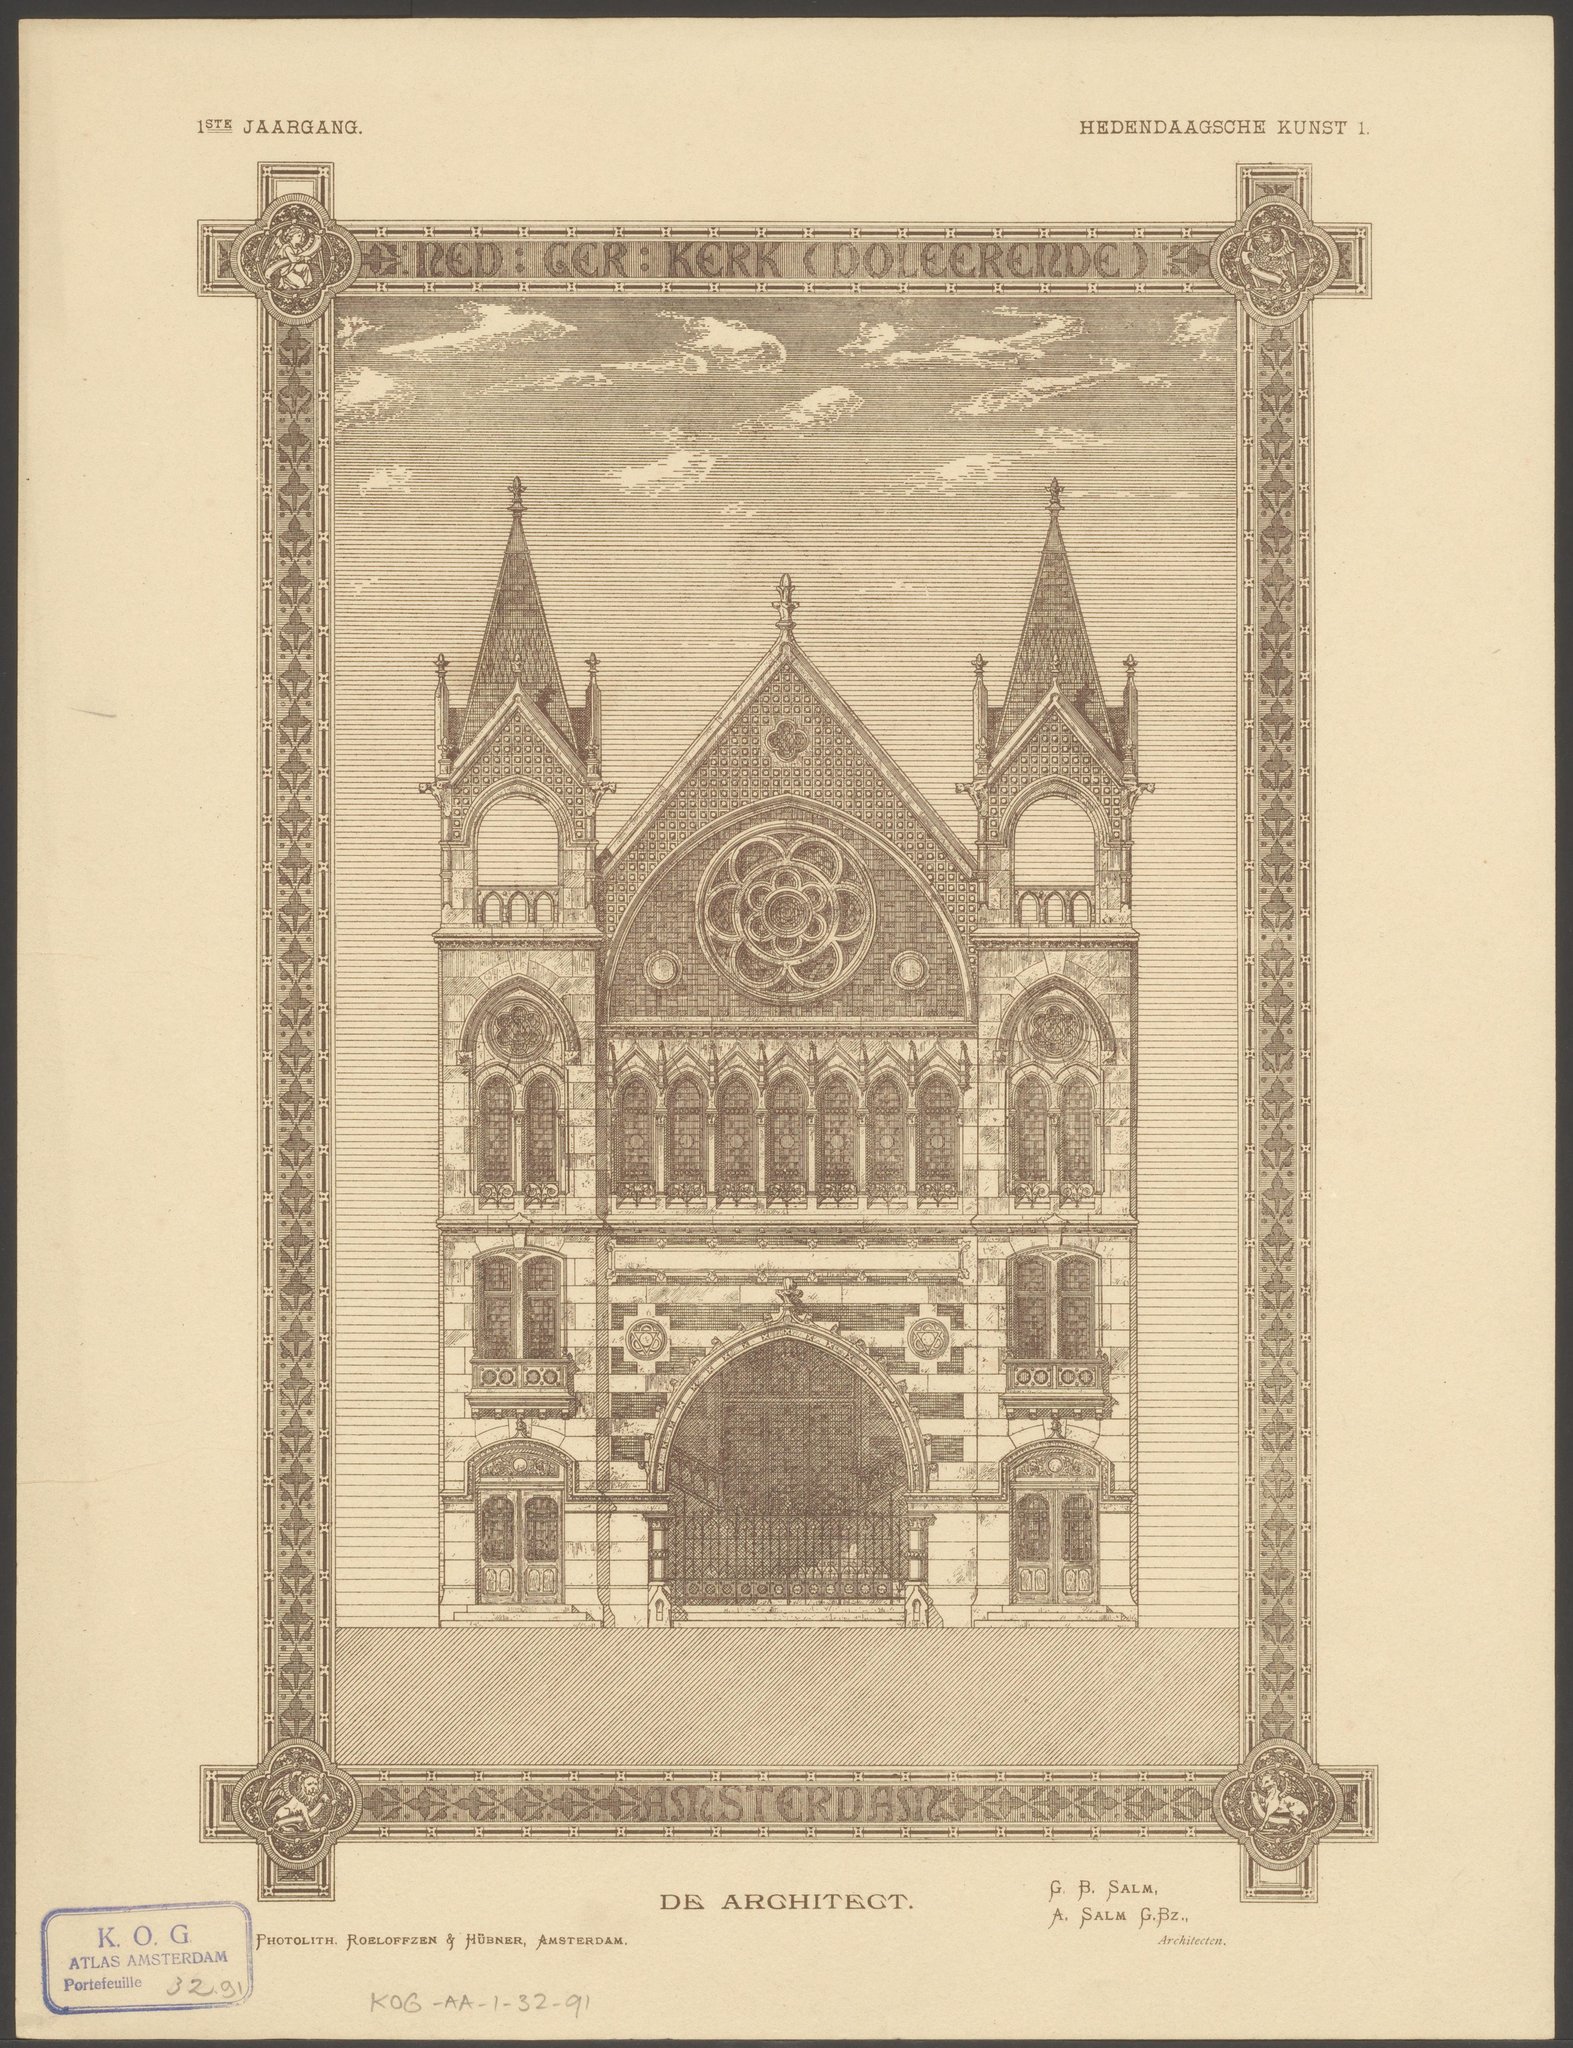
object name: photomechanical print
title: Ned: Ger: Kerk (Doleerende) / Amsterdam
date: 1890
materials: paper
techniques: photolithography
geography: amsterdam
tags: parts of church exterior and annexes: façade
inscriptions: collector's mark: Lugt 1641b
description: Onderwerpsrubriek binnen de Atlas Amsterdam: Kerkwezen: Hervormde Gemeente: Keizersgrachtkerk (Doleantie).